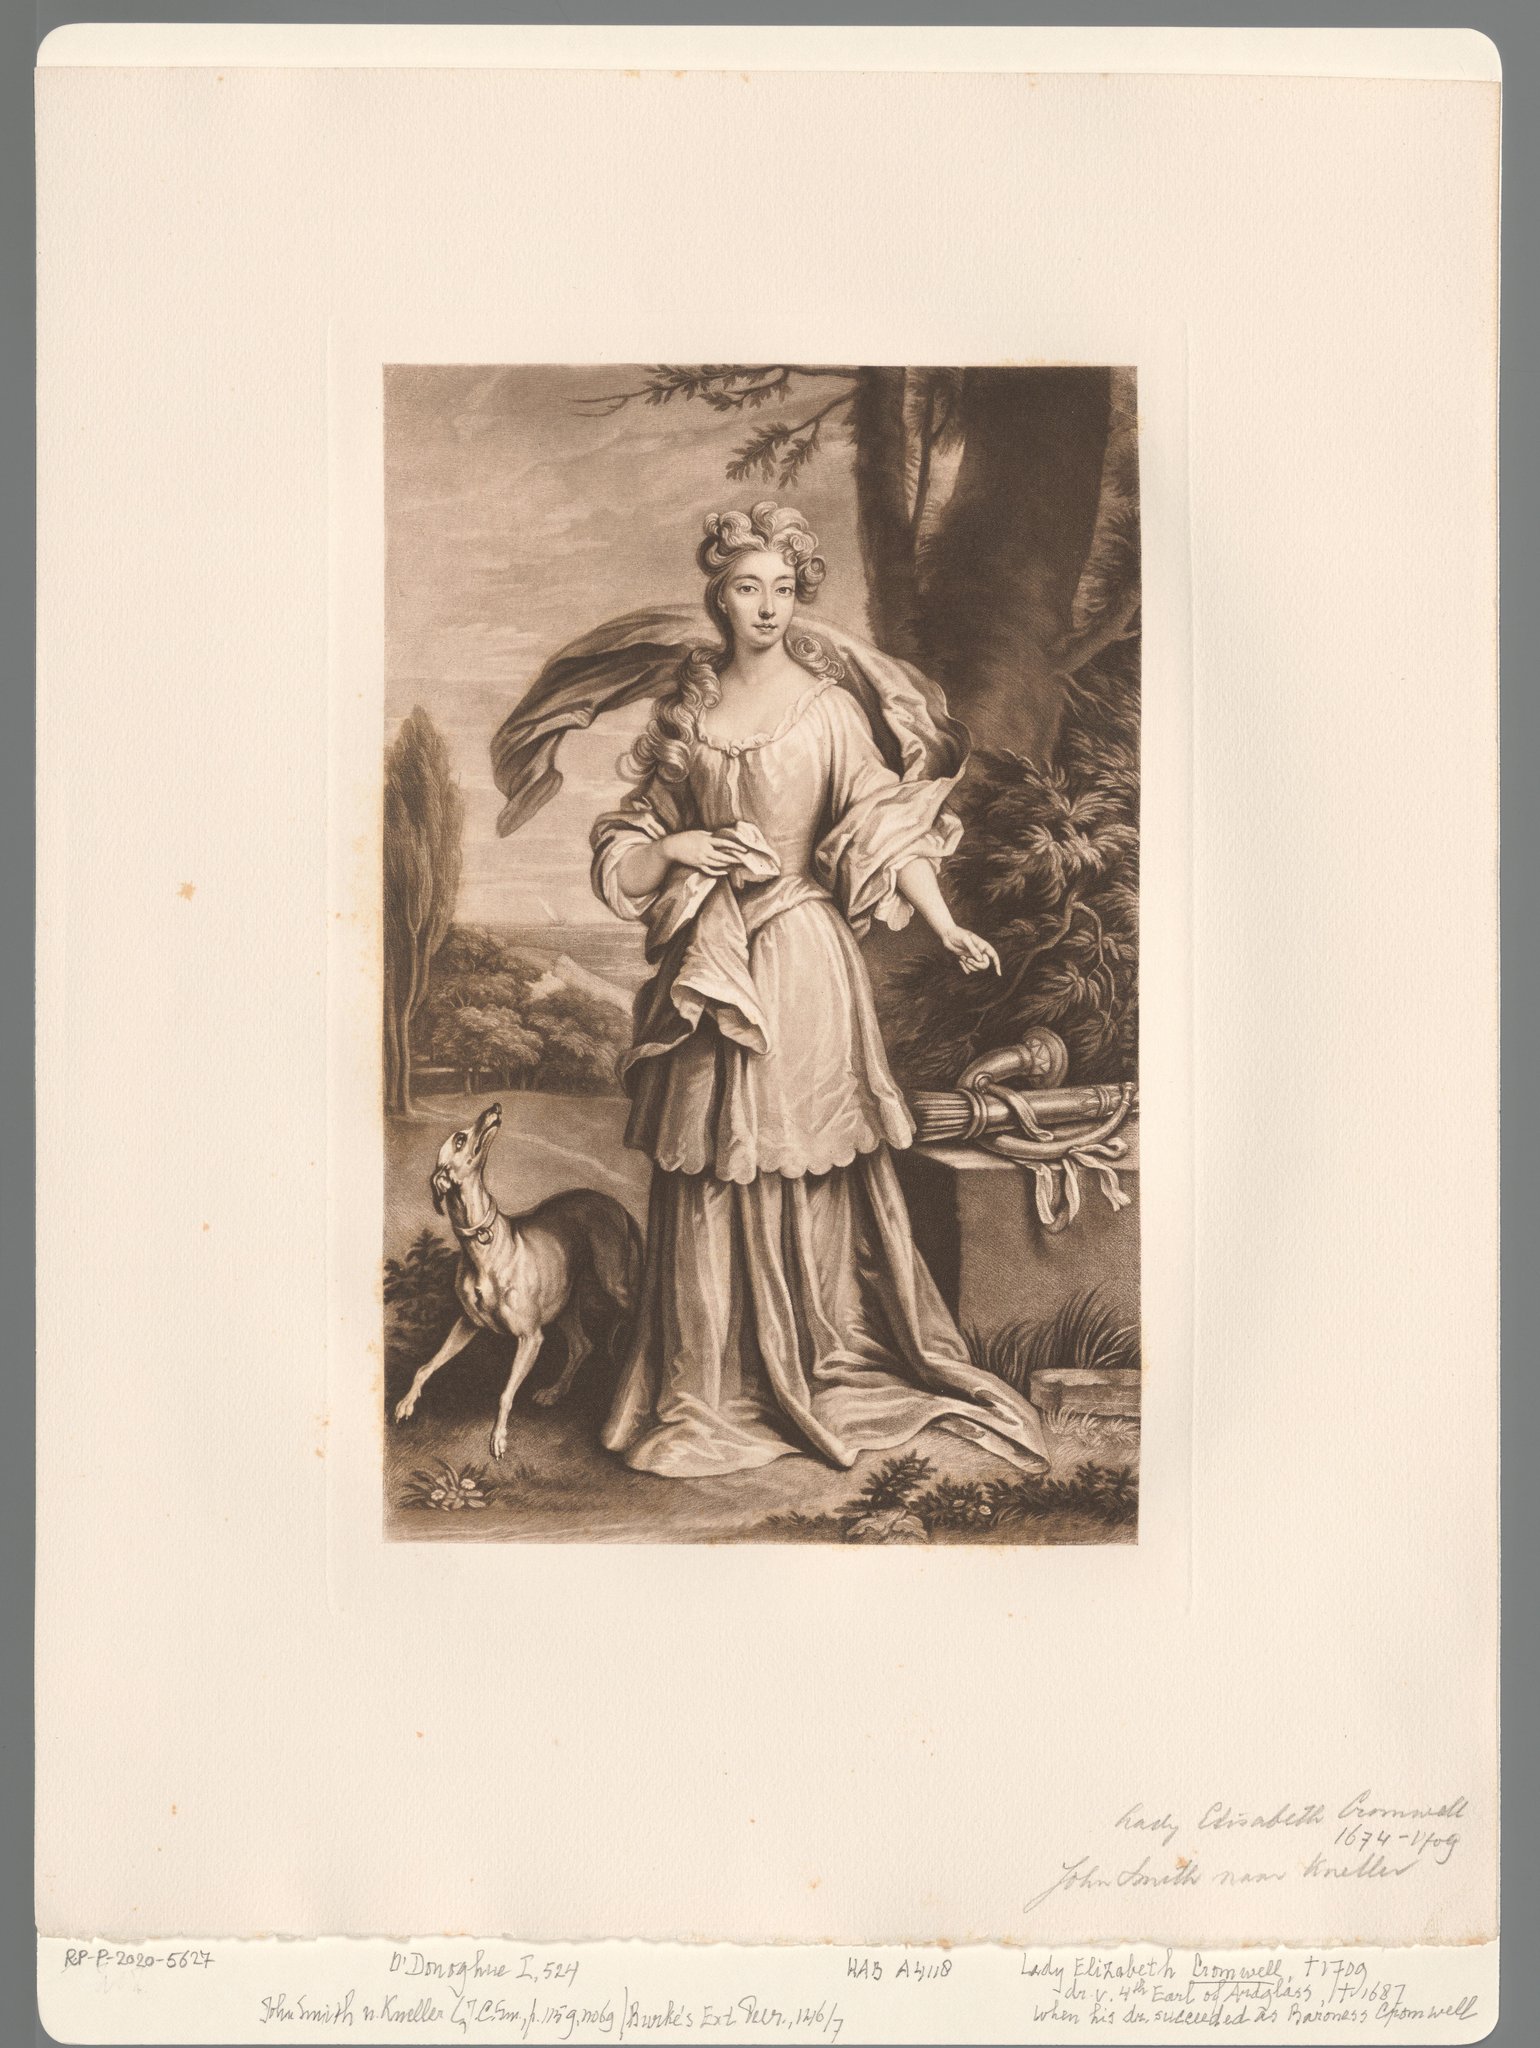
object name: photomechanical print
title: Portret van Elizabeth Cromwell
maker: Anonymous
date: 1870-1915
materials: paper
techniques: photoaquatint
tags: historical persons - bb - woman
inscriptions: collector's mark: Lugt 2228